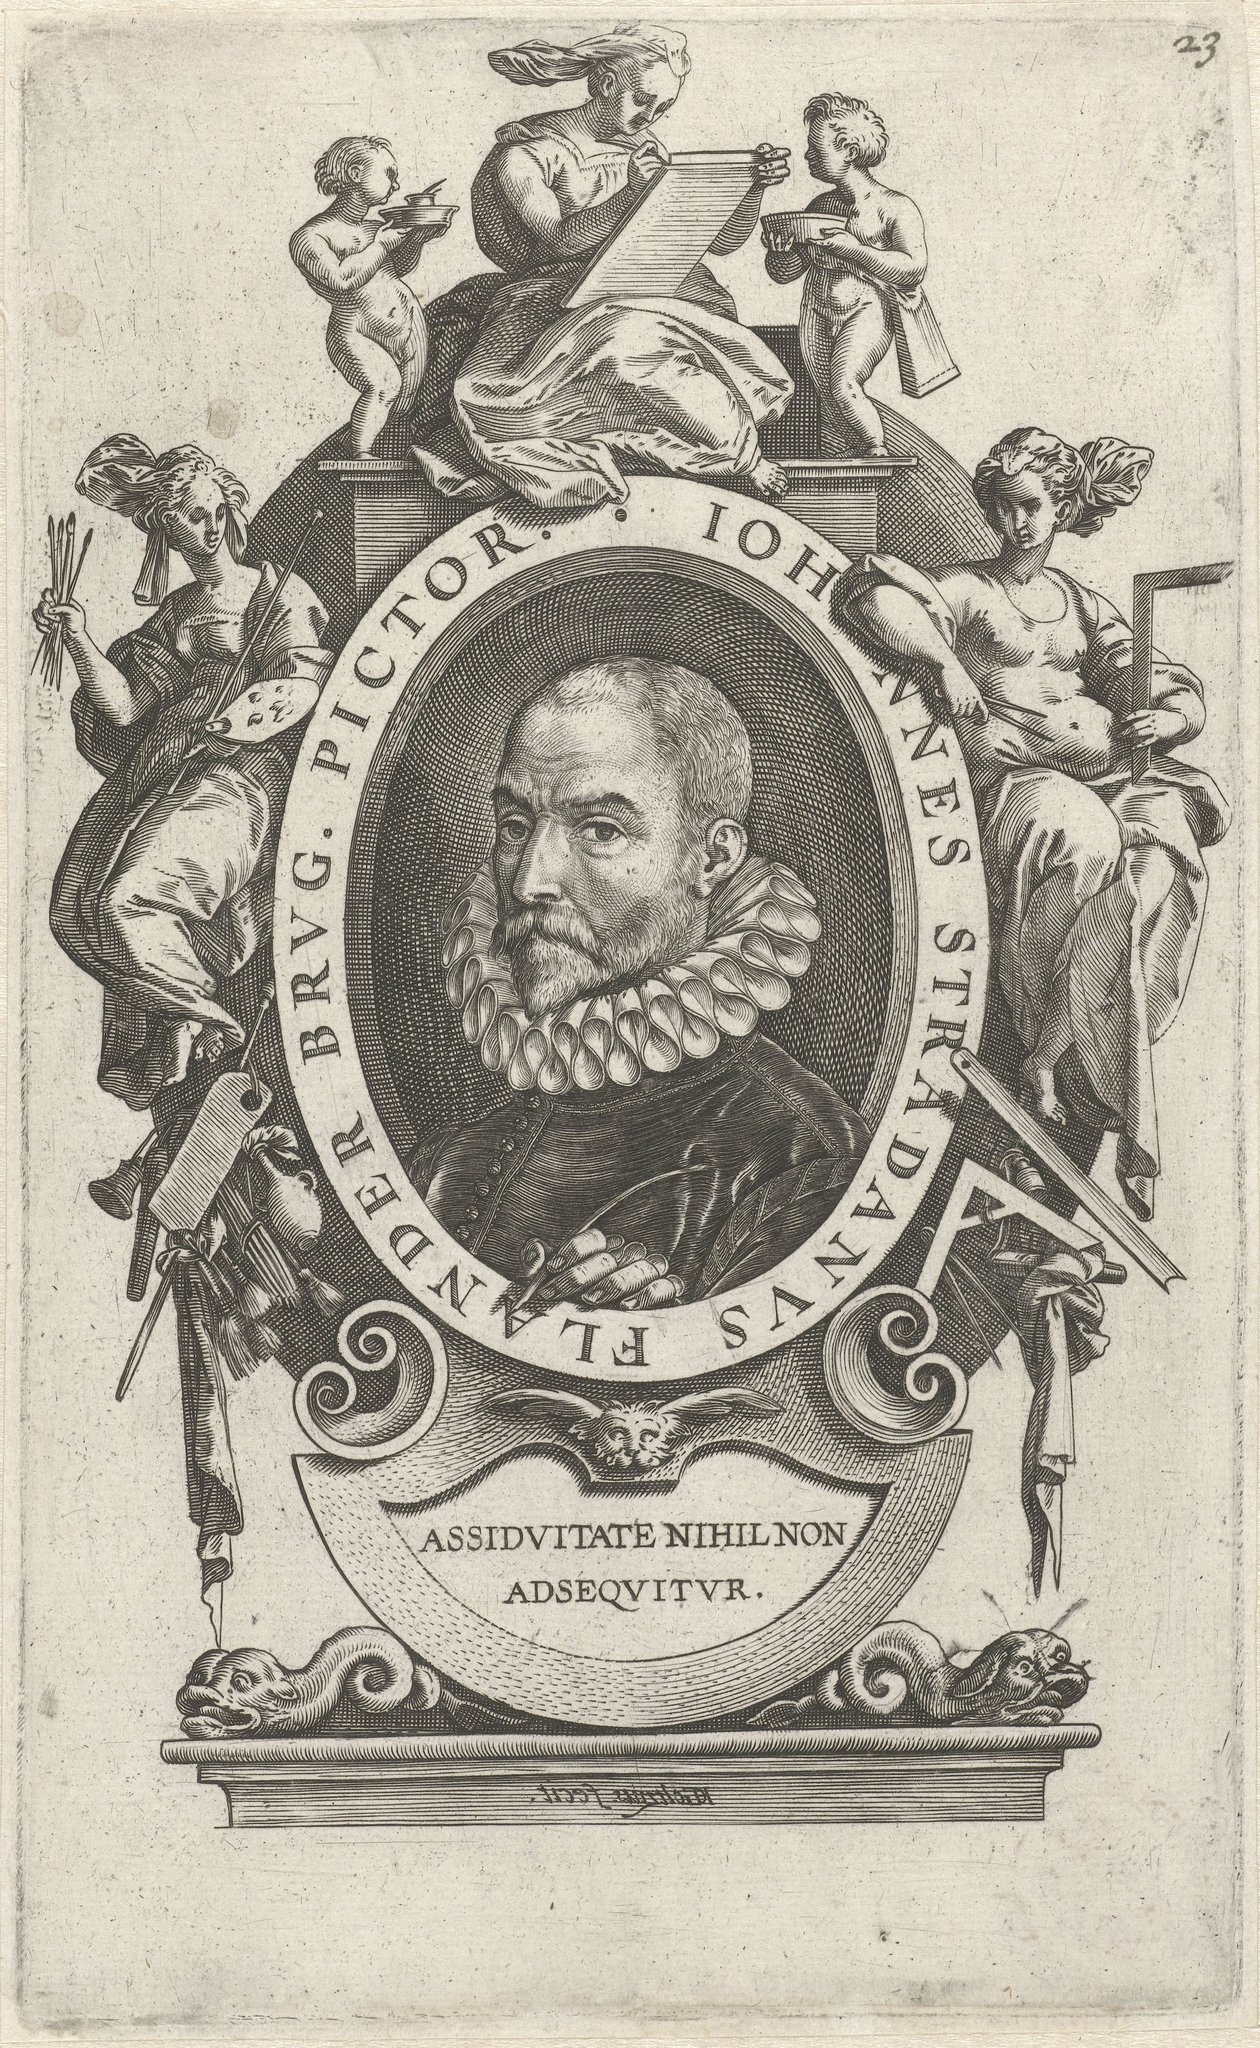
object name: print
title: Portret van de kunstenaar Jan van der Straet (Johannes Stradanus)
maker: hendrick goltzius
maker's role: draughtsman, painter, print maker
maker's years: 1558-1617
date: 1581-1583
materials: paper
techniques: engraving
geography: haarlem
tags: bruges, draughtsman, jan van der straet, 'pictura', symbolic representations, allegories and emblems ~ painting; 'pittura' (ripa), neck-gear ~ clothing (with name) (+ men's clothes), portrait, self-portrait of artist, 'architectura', symbolic representations, allegories and emblems ~ architecture; 'architettura' (ripa), symbolic representations, allegories and emblems ~ drawing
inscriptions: number: ‘23’, collector's mark: Lugt 240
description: Portret van Jan van der Straet (ook bekend onder zijn gelatiniseerde naam Johannes Stradanus), in ovaal met figurale omlijsting. In de omlijsting zijn de personificaties van de Schilderkunst, Tekenkunst en Architectuur met hun diverse attributen verwerkt.